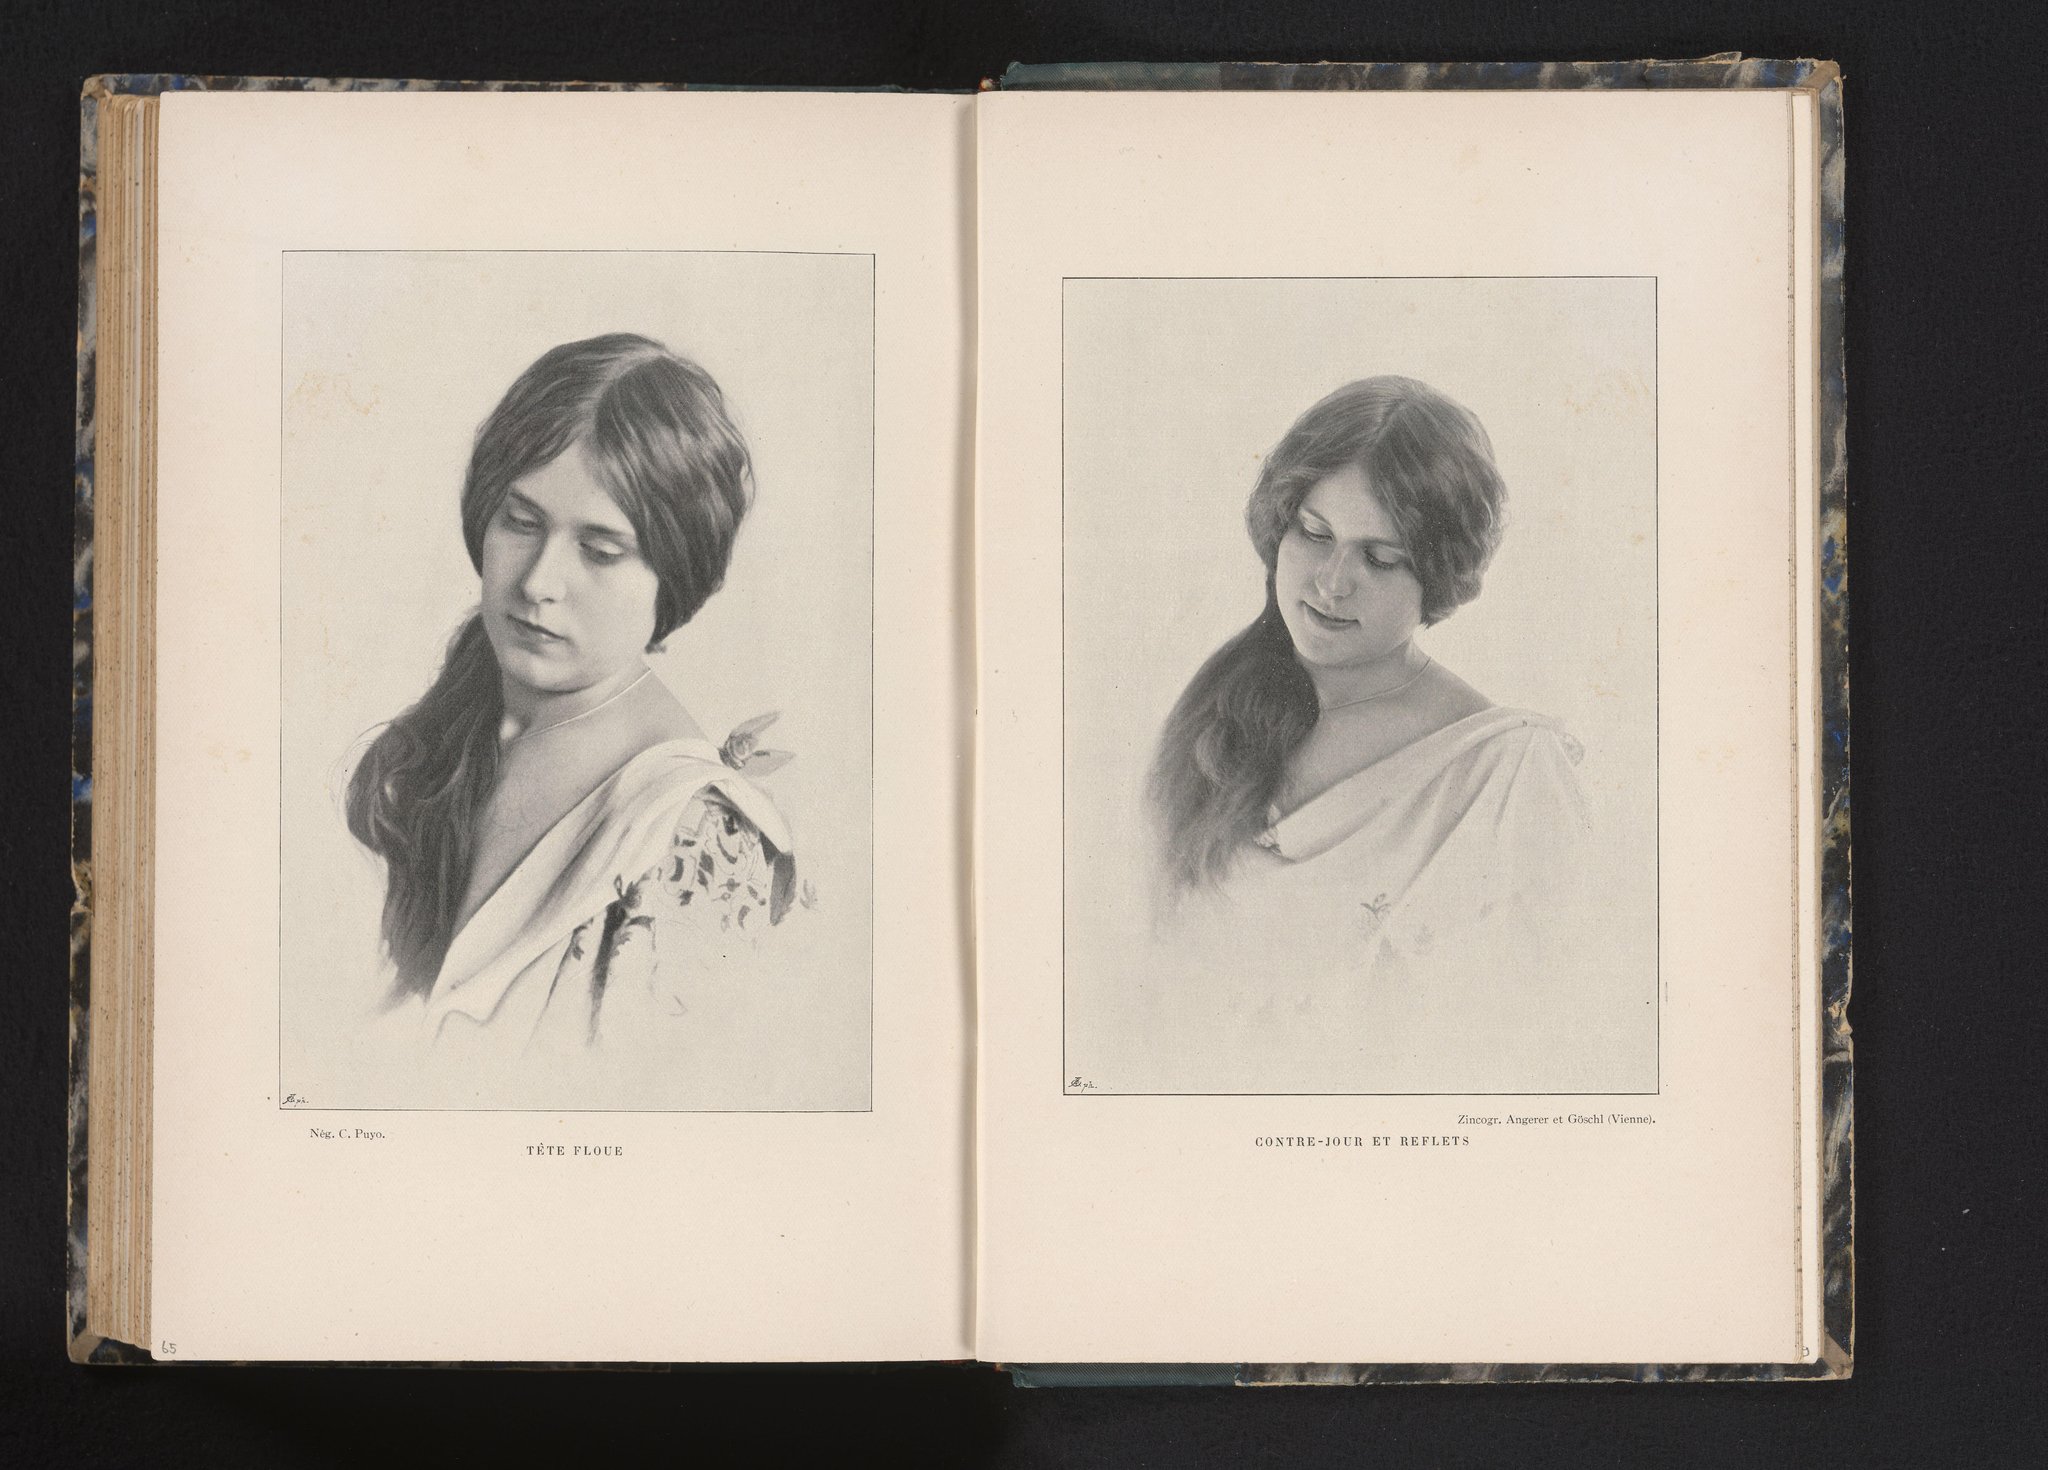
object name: page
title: Portret van een onbekende vrouw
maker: constant puyo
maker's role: fotograaf, schrijver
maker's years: 1857-1933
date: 1891-1896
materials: paper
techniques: autotype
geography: vienna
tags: historical persons - bb - woman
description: Prent op derde ongenummerde pagina na pagina 8 van het supplement Note sur l'Art photographique achterin het boek.